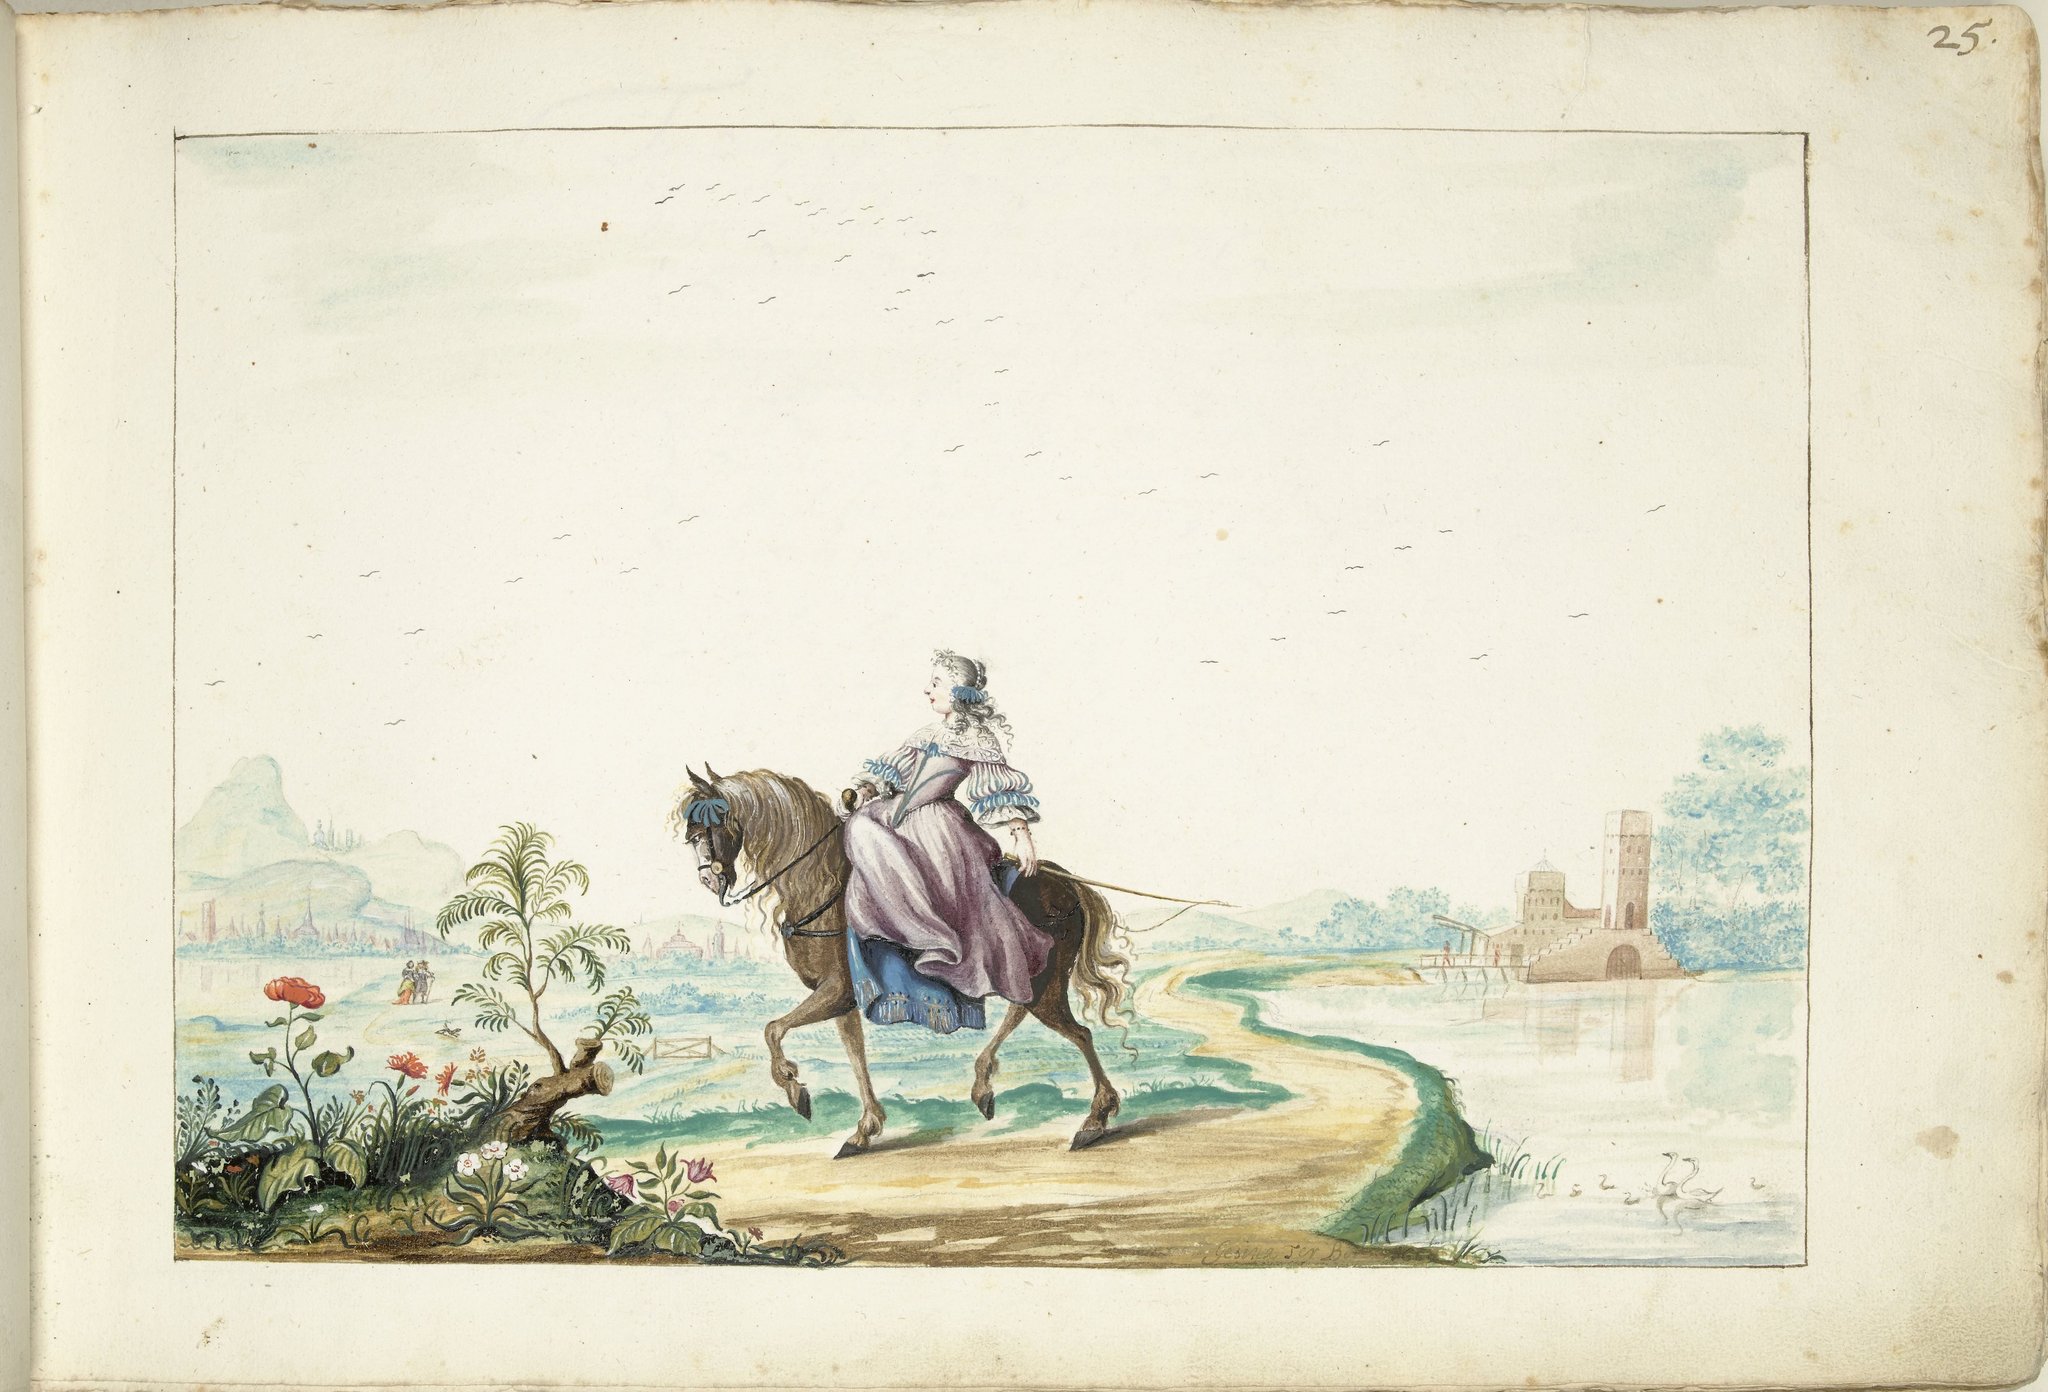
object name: watercolor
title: Vrouw te paard in een landschap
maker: gesina ter borch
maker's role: draughtsman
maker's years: 1633-1690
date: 1660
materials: ink, paper, watercolor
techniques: brush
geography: zwolle